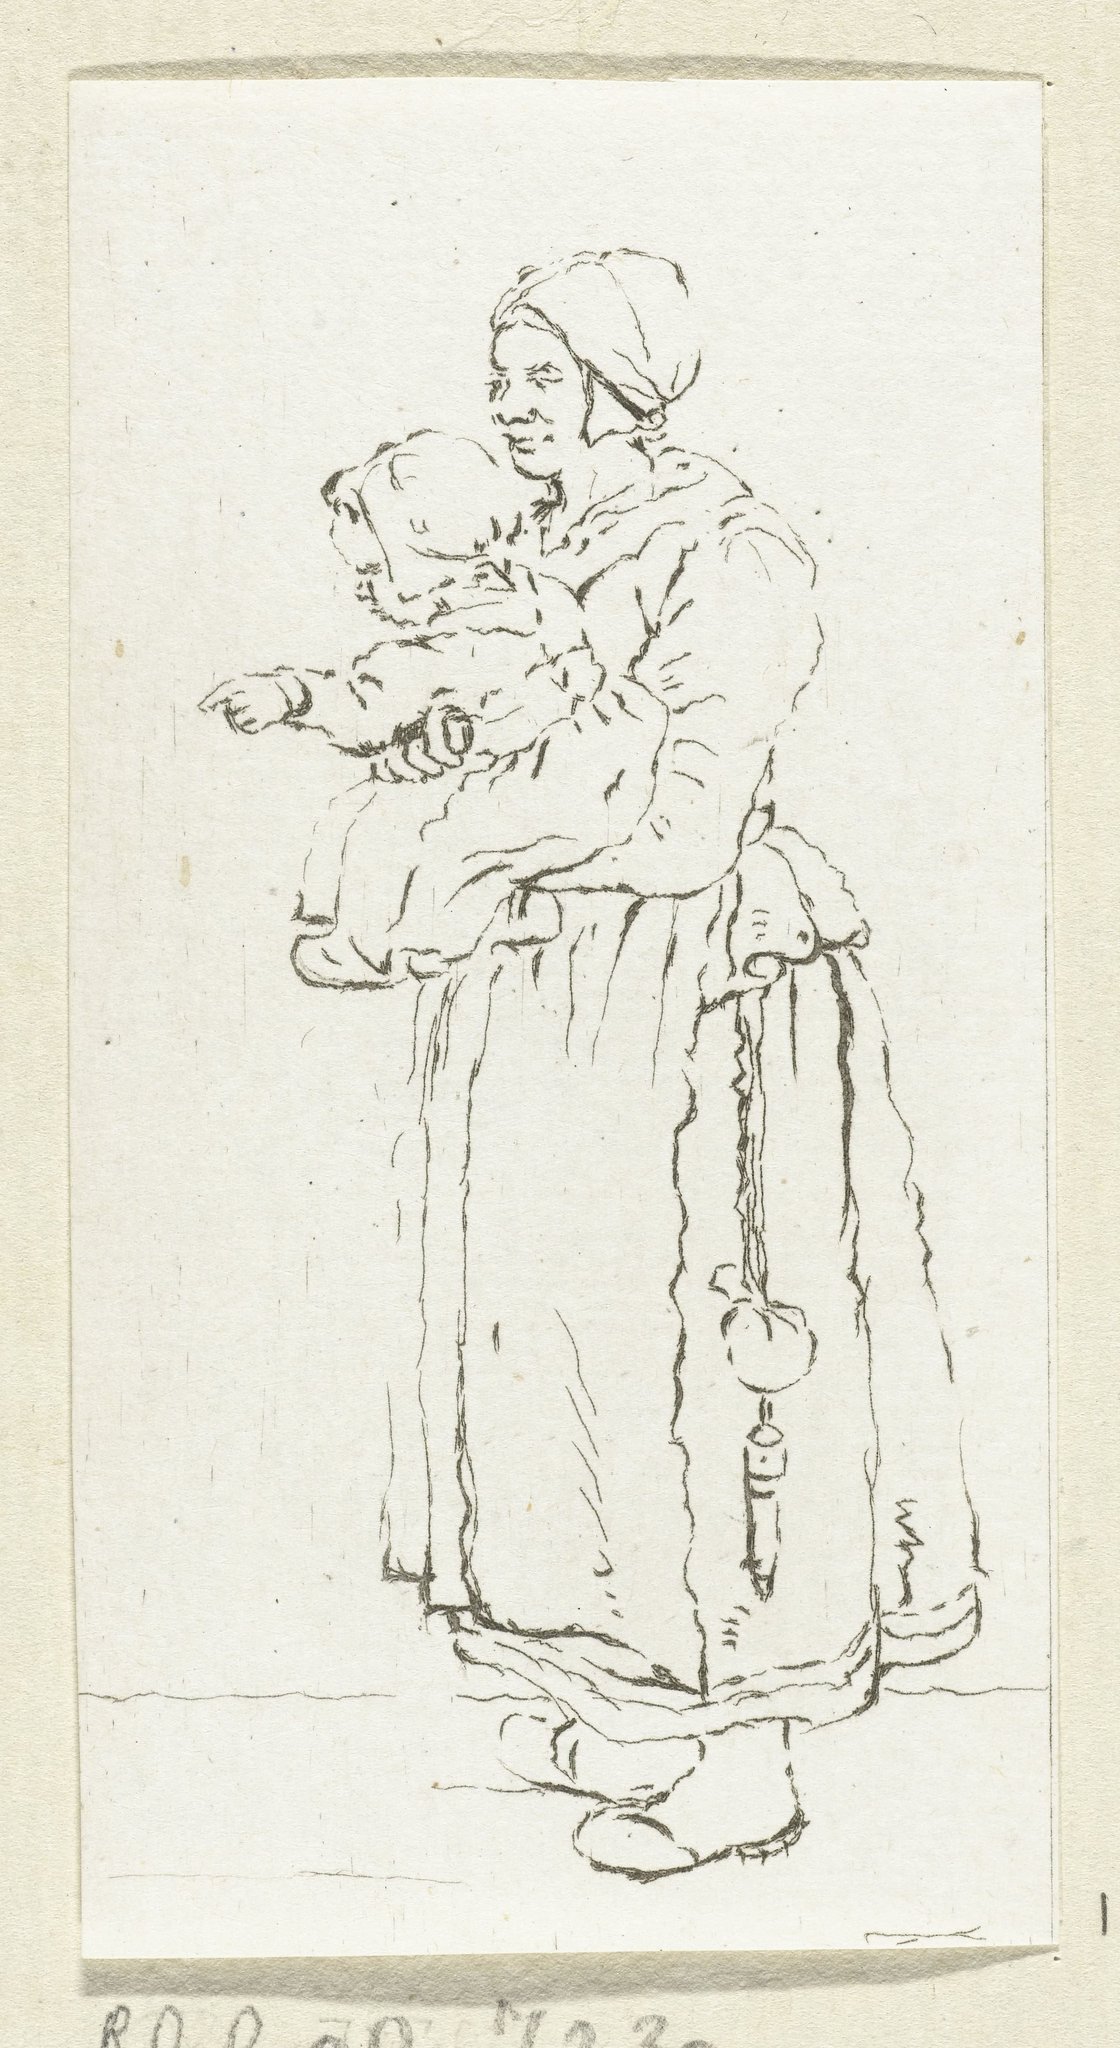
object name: print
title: Staande moeder met kind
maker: pieter de mare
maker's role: print maker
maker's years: 1758-1796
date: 1779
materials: paper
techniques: etching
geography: leiden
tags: mother and child(ren), woman and child(ren) (family group) (with number of children)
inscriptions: collector's mark: Lugt 2228